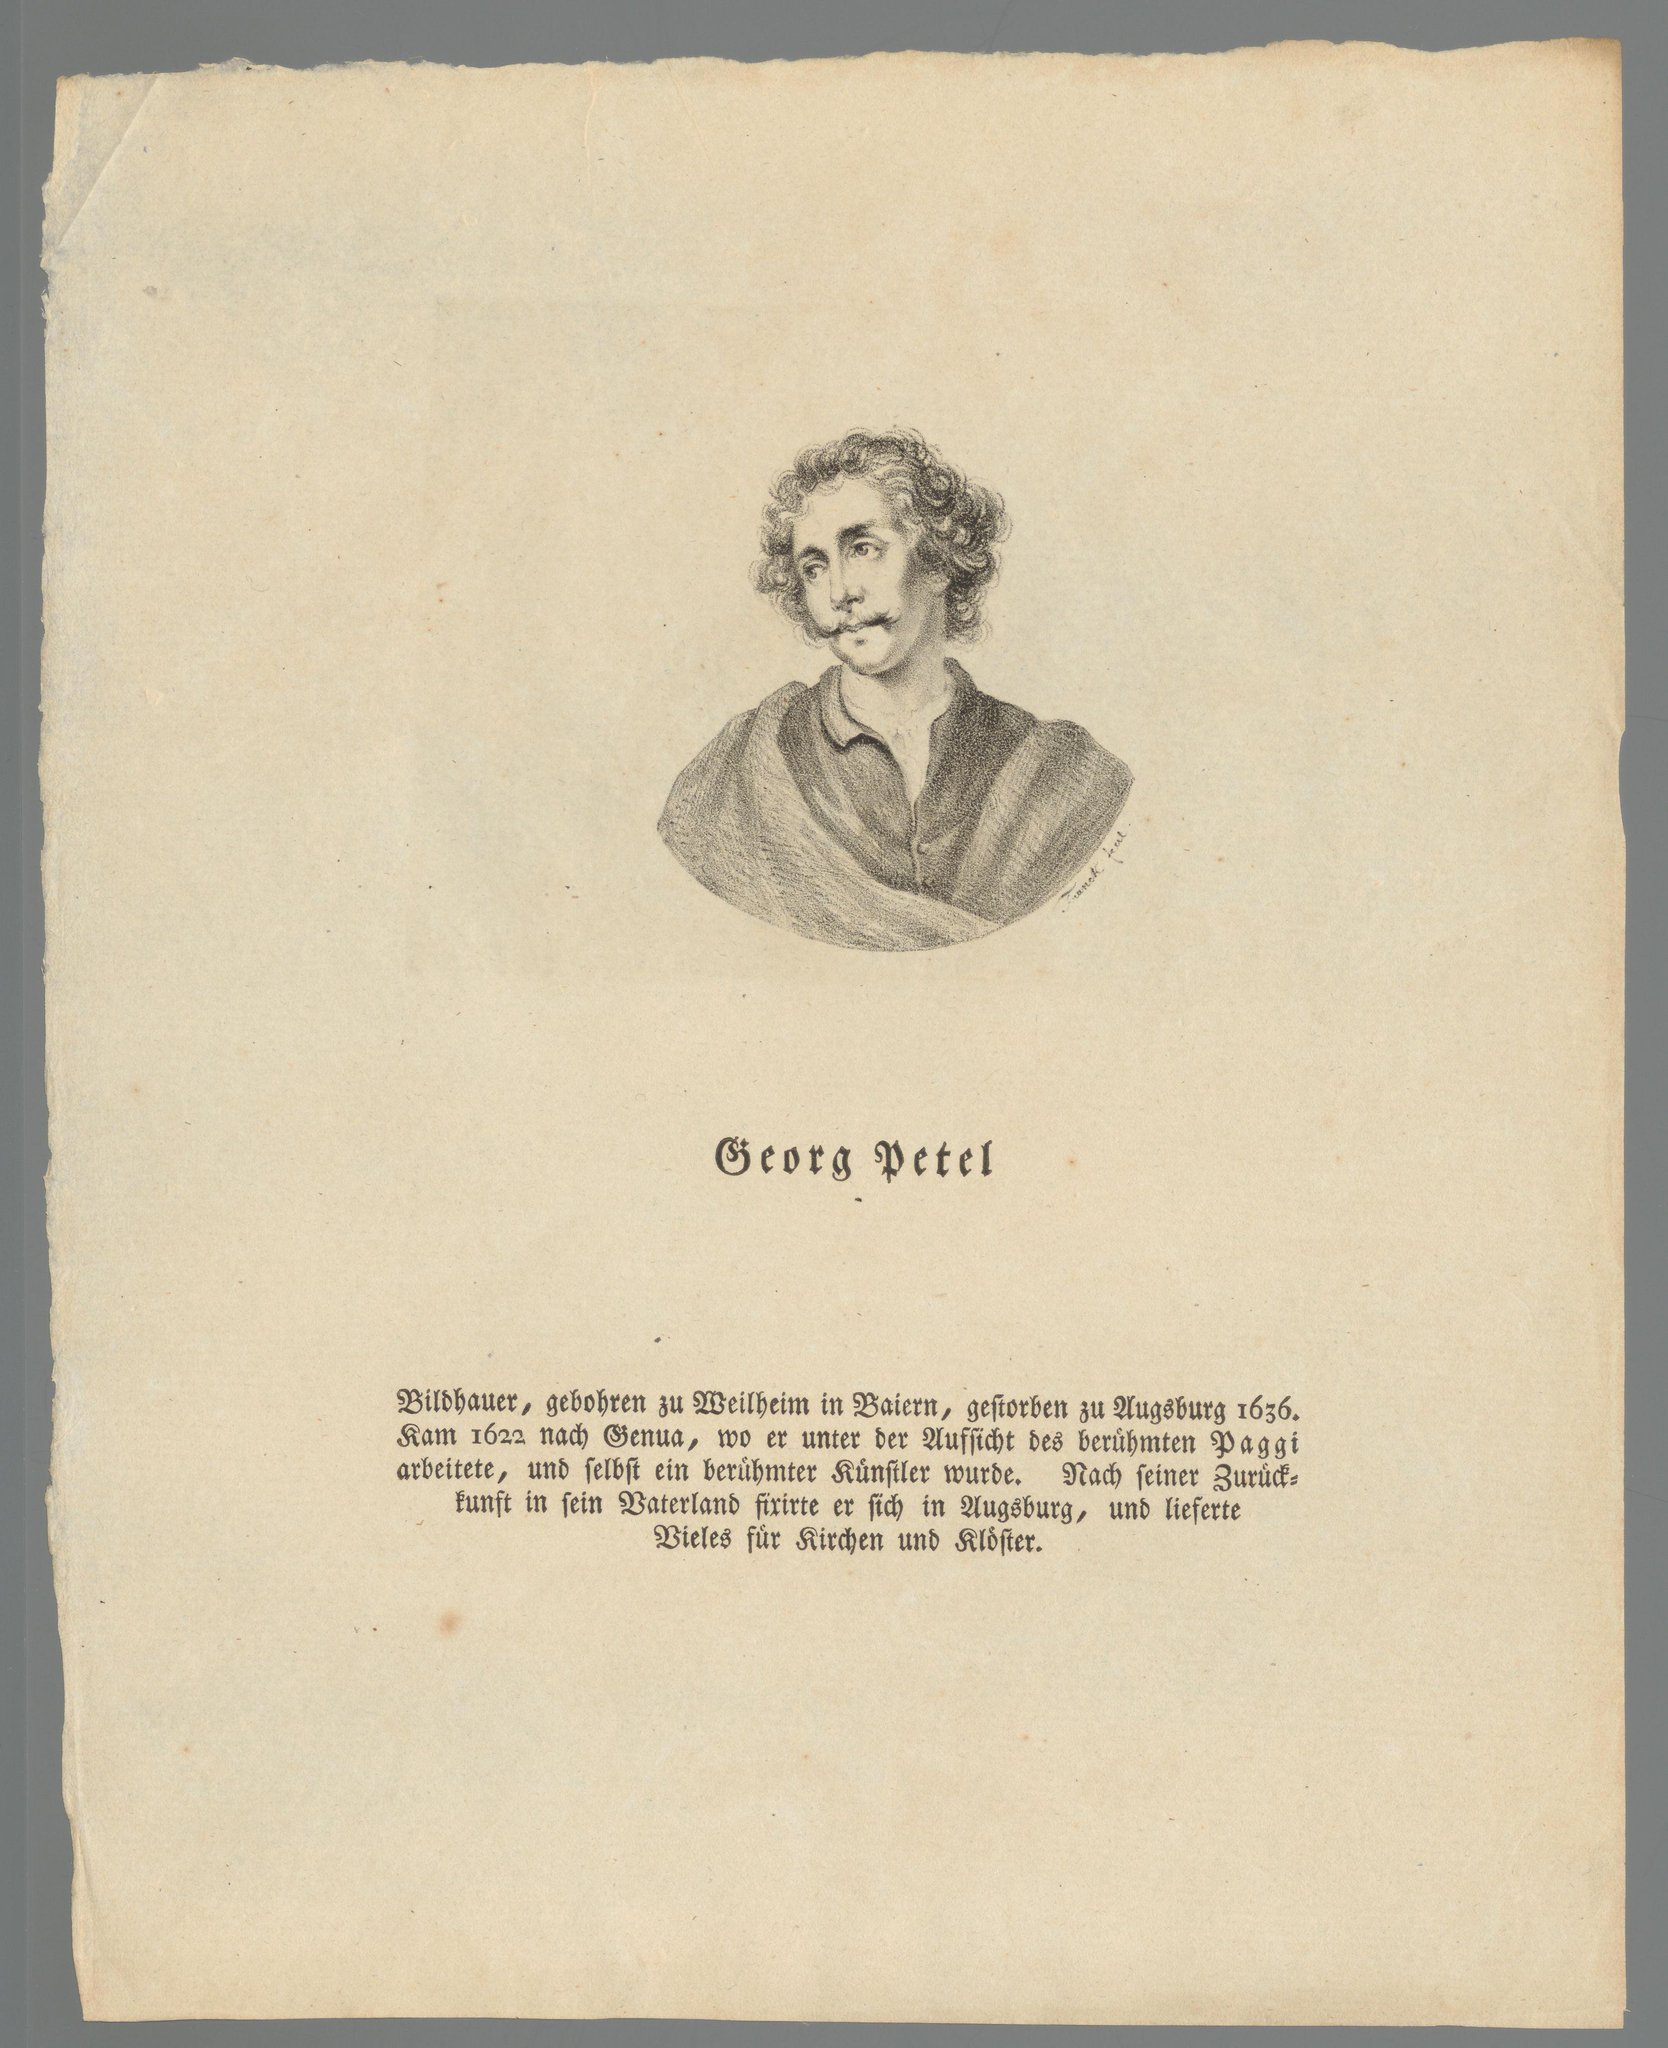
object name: print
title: Georg Petel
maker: maximilian franck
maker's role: print maker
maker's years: 1780-1830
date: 1813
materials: paper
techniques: letterpress printing, lithograph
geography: munich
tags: sculptor, ivory carver, portrait, self-portrait of sculptor, historical persons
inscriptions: collector's mark: Lugt 2228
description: Prent uit: Lindauer, Joseph. Deutsche Künstler-Gallerie. München: Maximilian Franck, 1813.